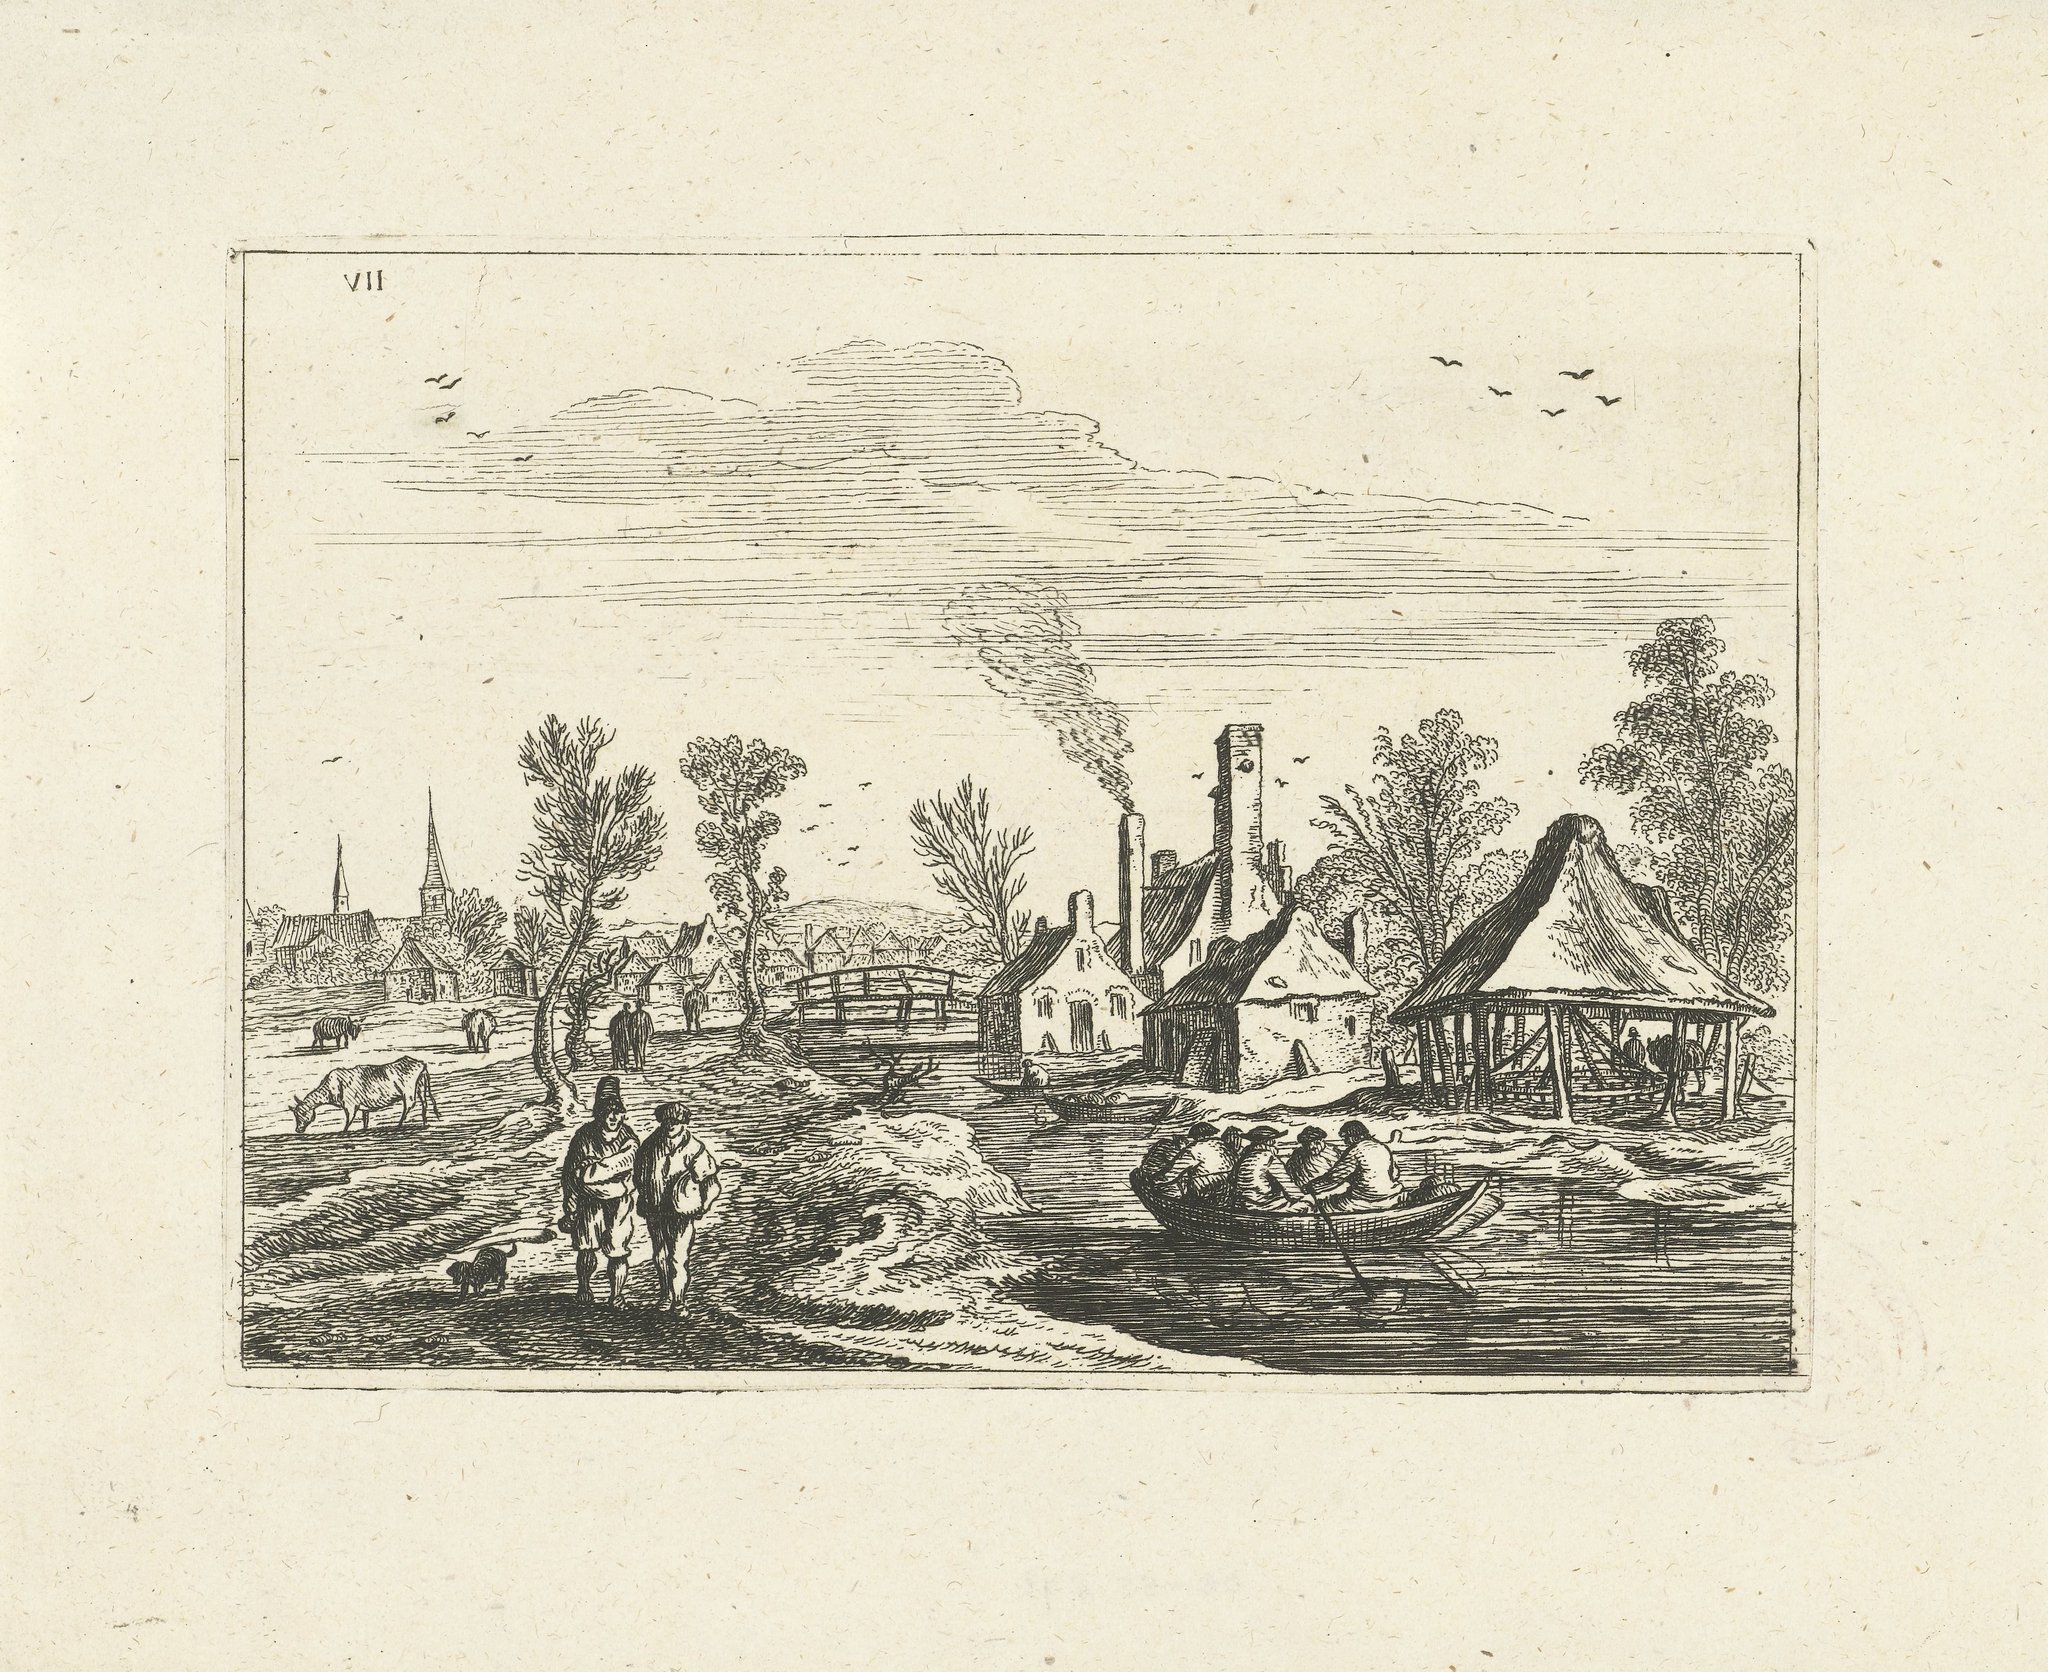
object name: print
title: Landschappen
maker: johannes gronsveld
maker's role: draughtsman, painter, print maker, publisher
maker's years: 1658-1728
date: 1679-1728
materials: paper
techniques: engraving, etching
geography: amsterdam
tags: village, rowing-boat, canoe, etc.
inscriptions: collector's mark: Lugt 240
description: Landschap met dorp aan rivier met rechts op de voorgrond mannen in een roeiboot en links twee mannen en een hond wandelend over een pad langs de rivier. Zevende prent uit een serie van acht met landschappen.